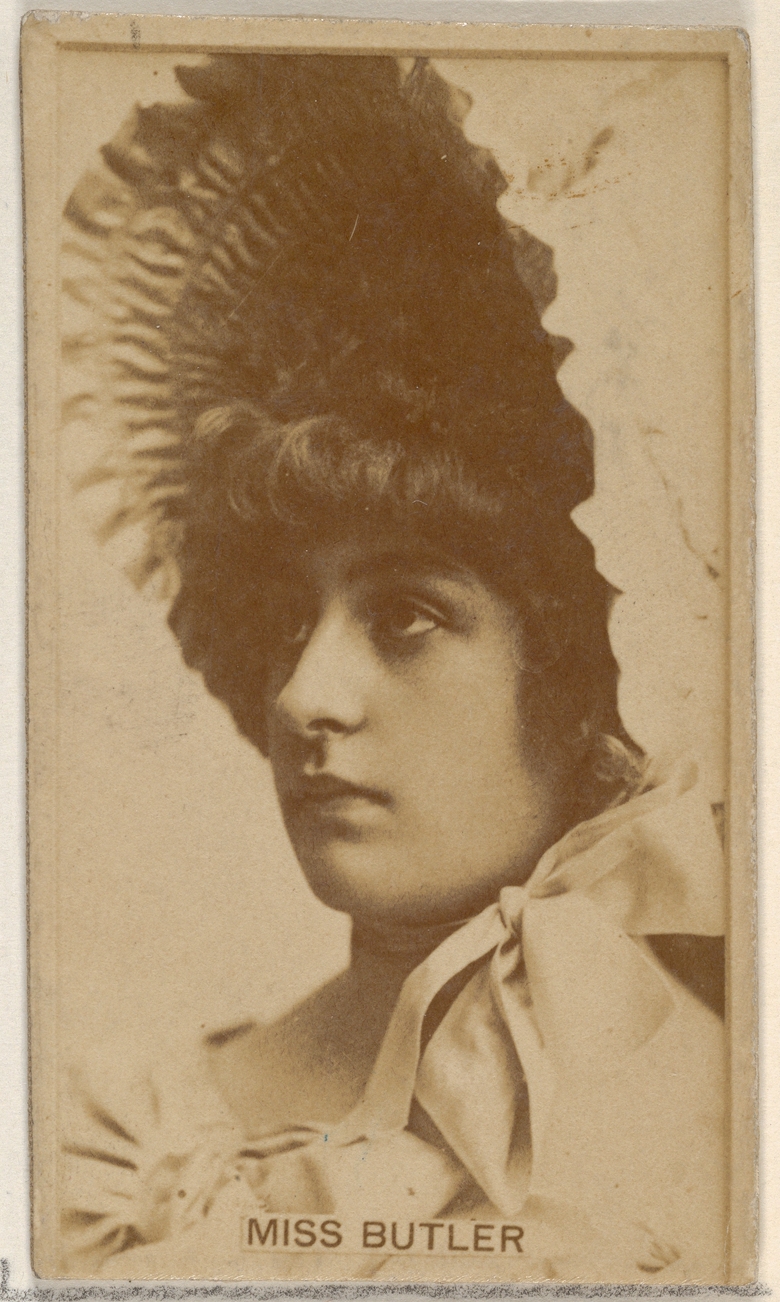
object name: photograph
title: Miss Butler, from the Actors and Actresses series (N45, Type 8) for Virginia Brights Cigarettes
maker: allen & ginter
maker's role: publisher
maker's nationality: american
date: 1888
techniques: albumen silver print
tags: portraits,women,actresses